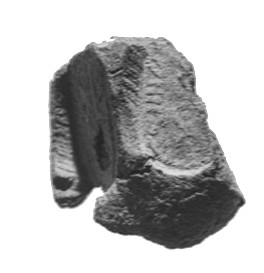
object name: sealing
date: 2030-1640 BCE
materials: clay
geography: egypt